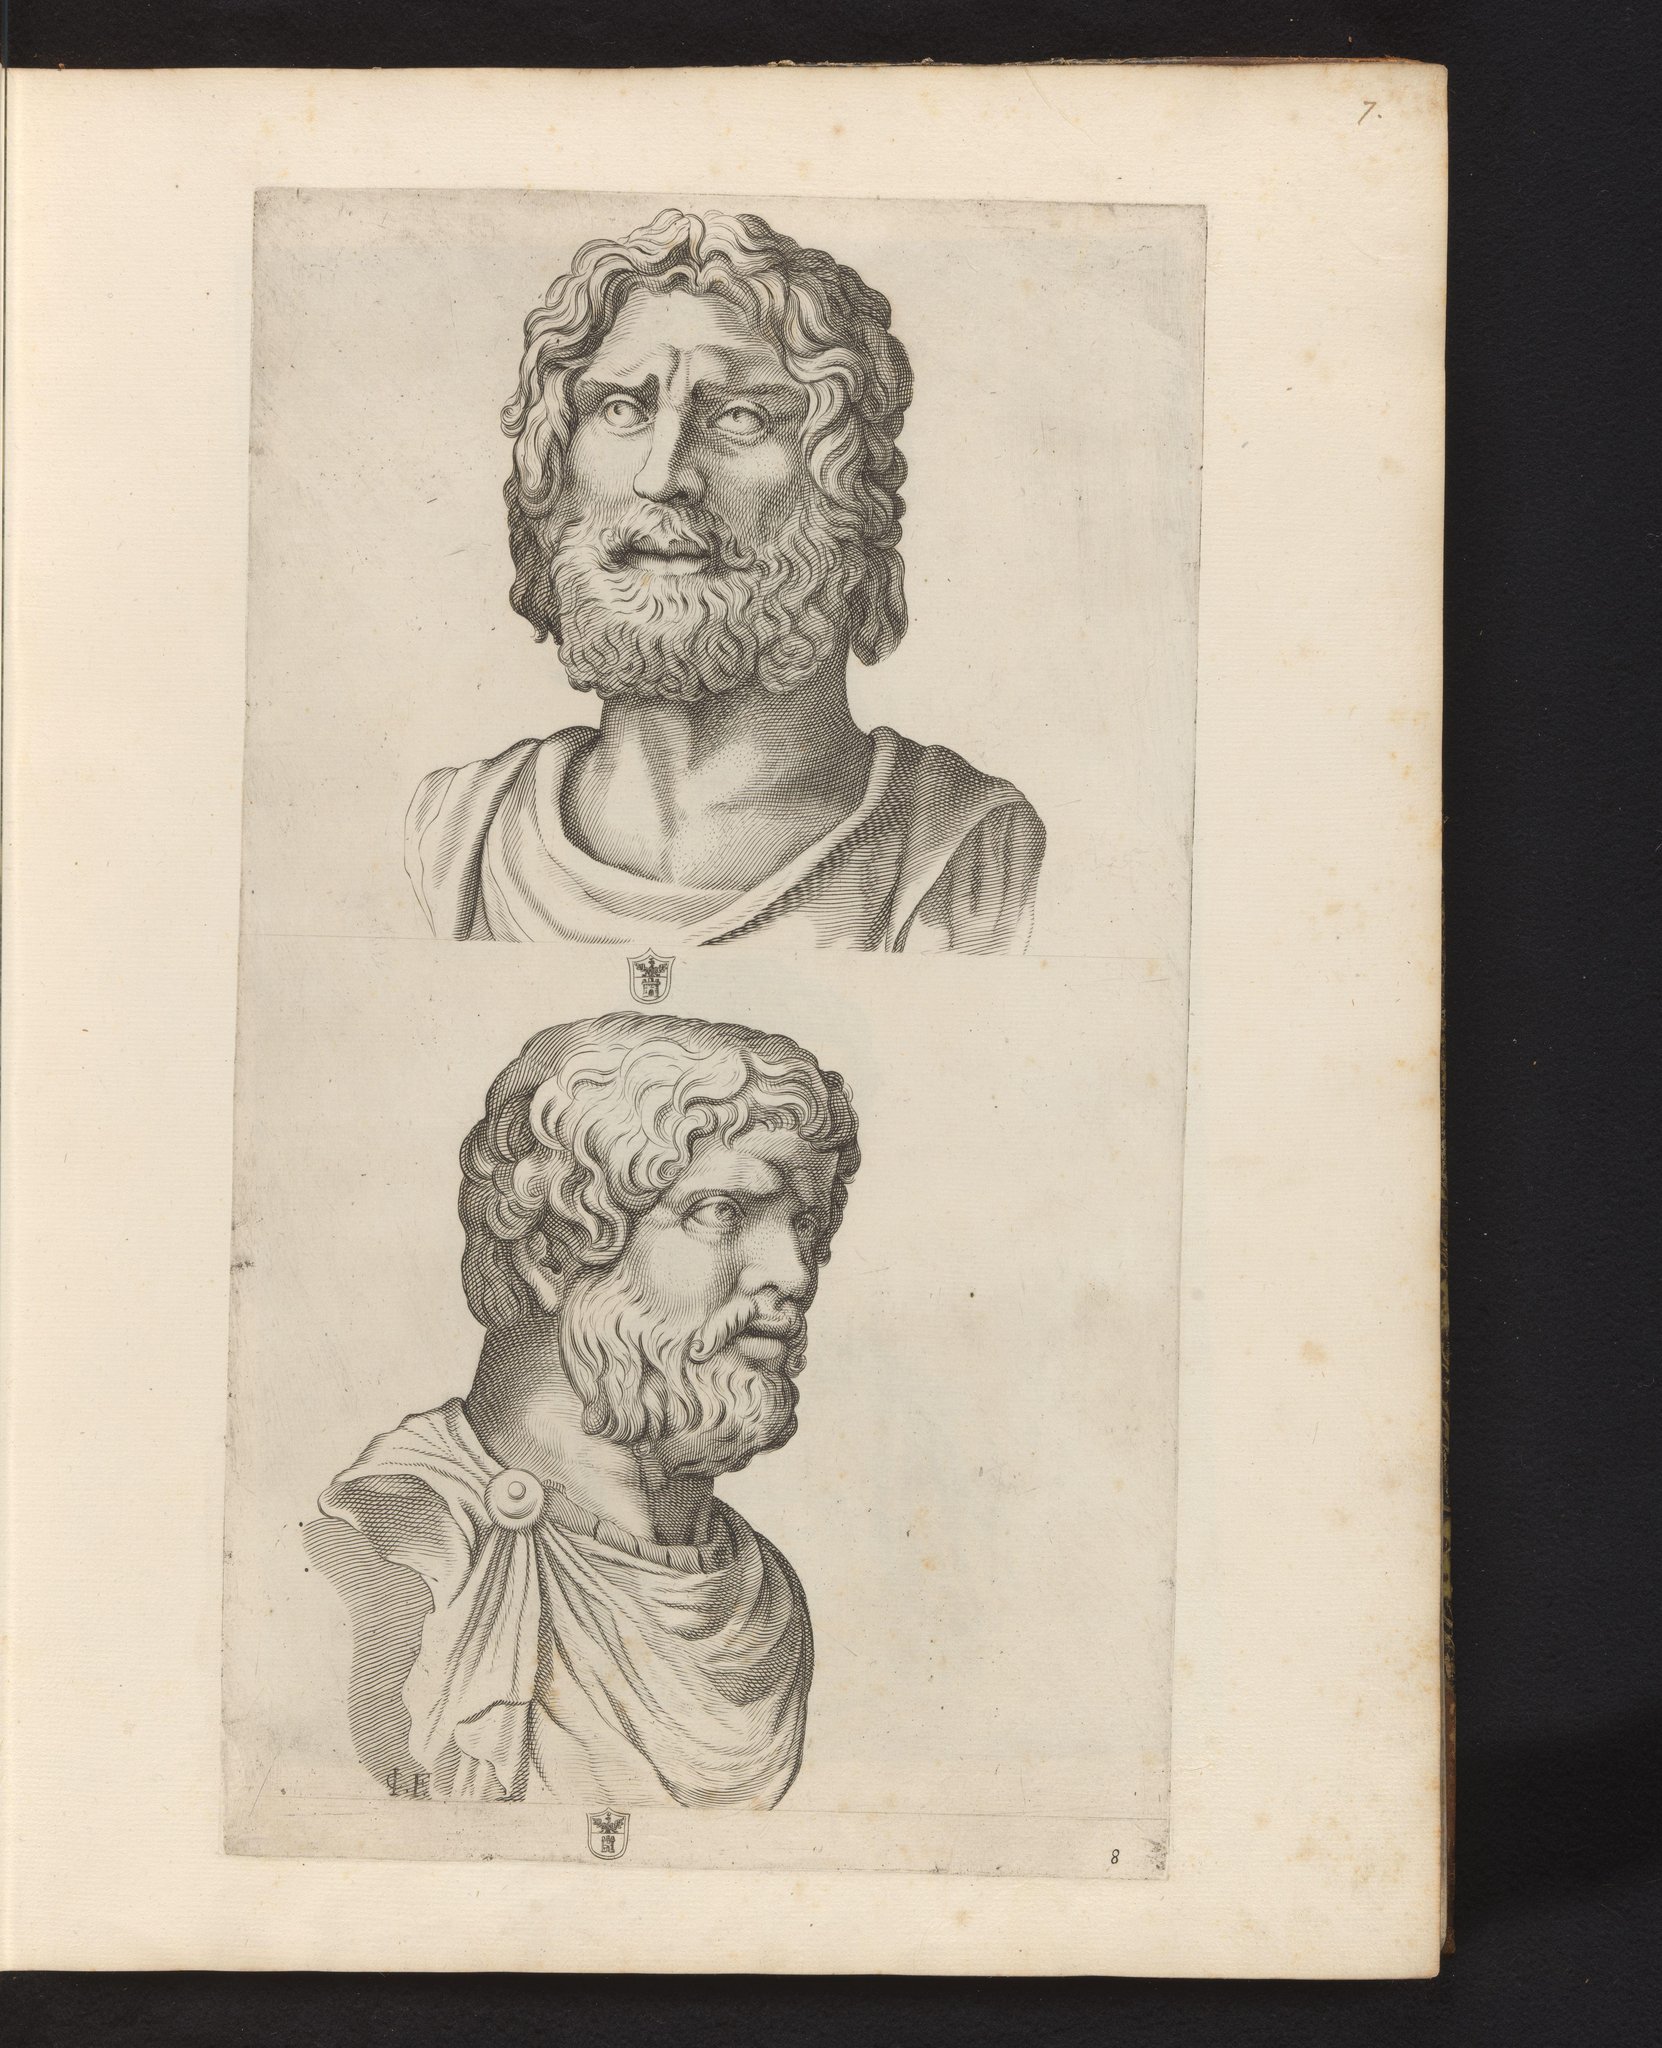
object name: print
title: Galleria Giustiniana del Marchese Vincenzo Giustiniani II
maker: joan comin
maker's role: print maker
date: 1636-1647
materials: paper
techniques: engraving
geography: rome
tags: male persons from classical history (+ head, bust, etc.), piece of sculpture, reproduction of a piece of sculpture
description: Twee Romeinse portretbustes. Onderaan het wapenschild van Vincenzo Giustiniani. Prent maakt deel uit van een album met een serie prenten naar de sculpturen in de verzameling in de Galleria Giustiniani te Rome.